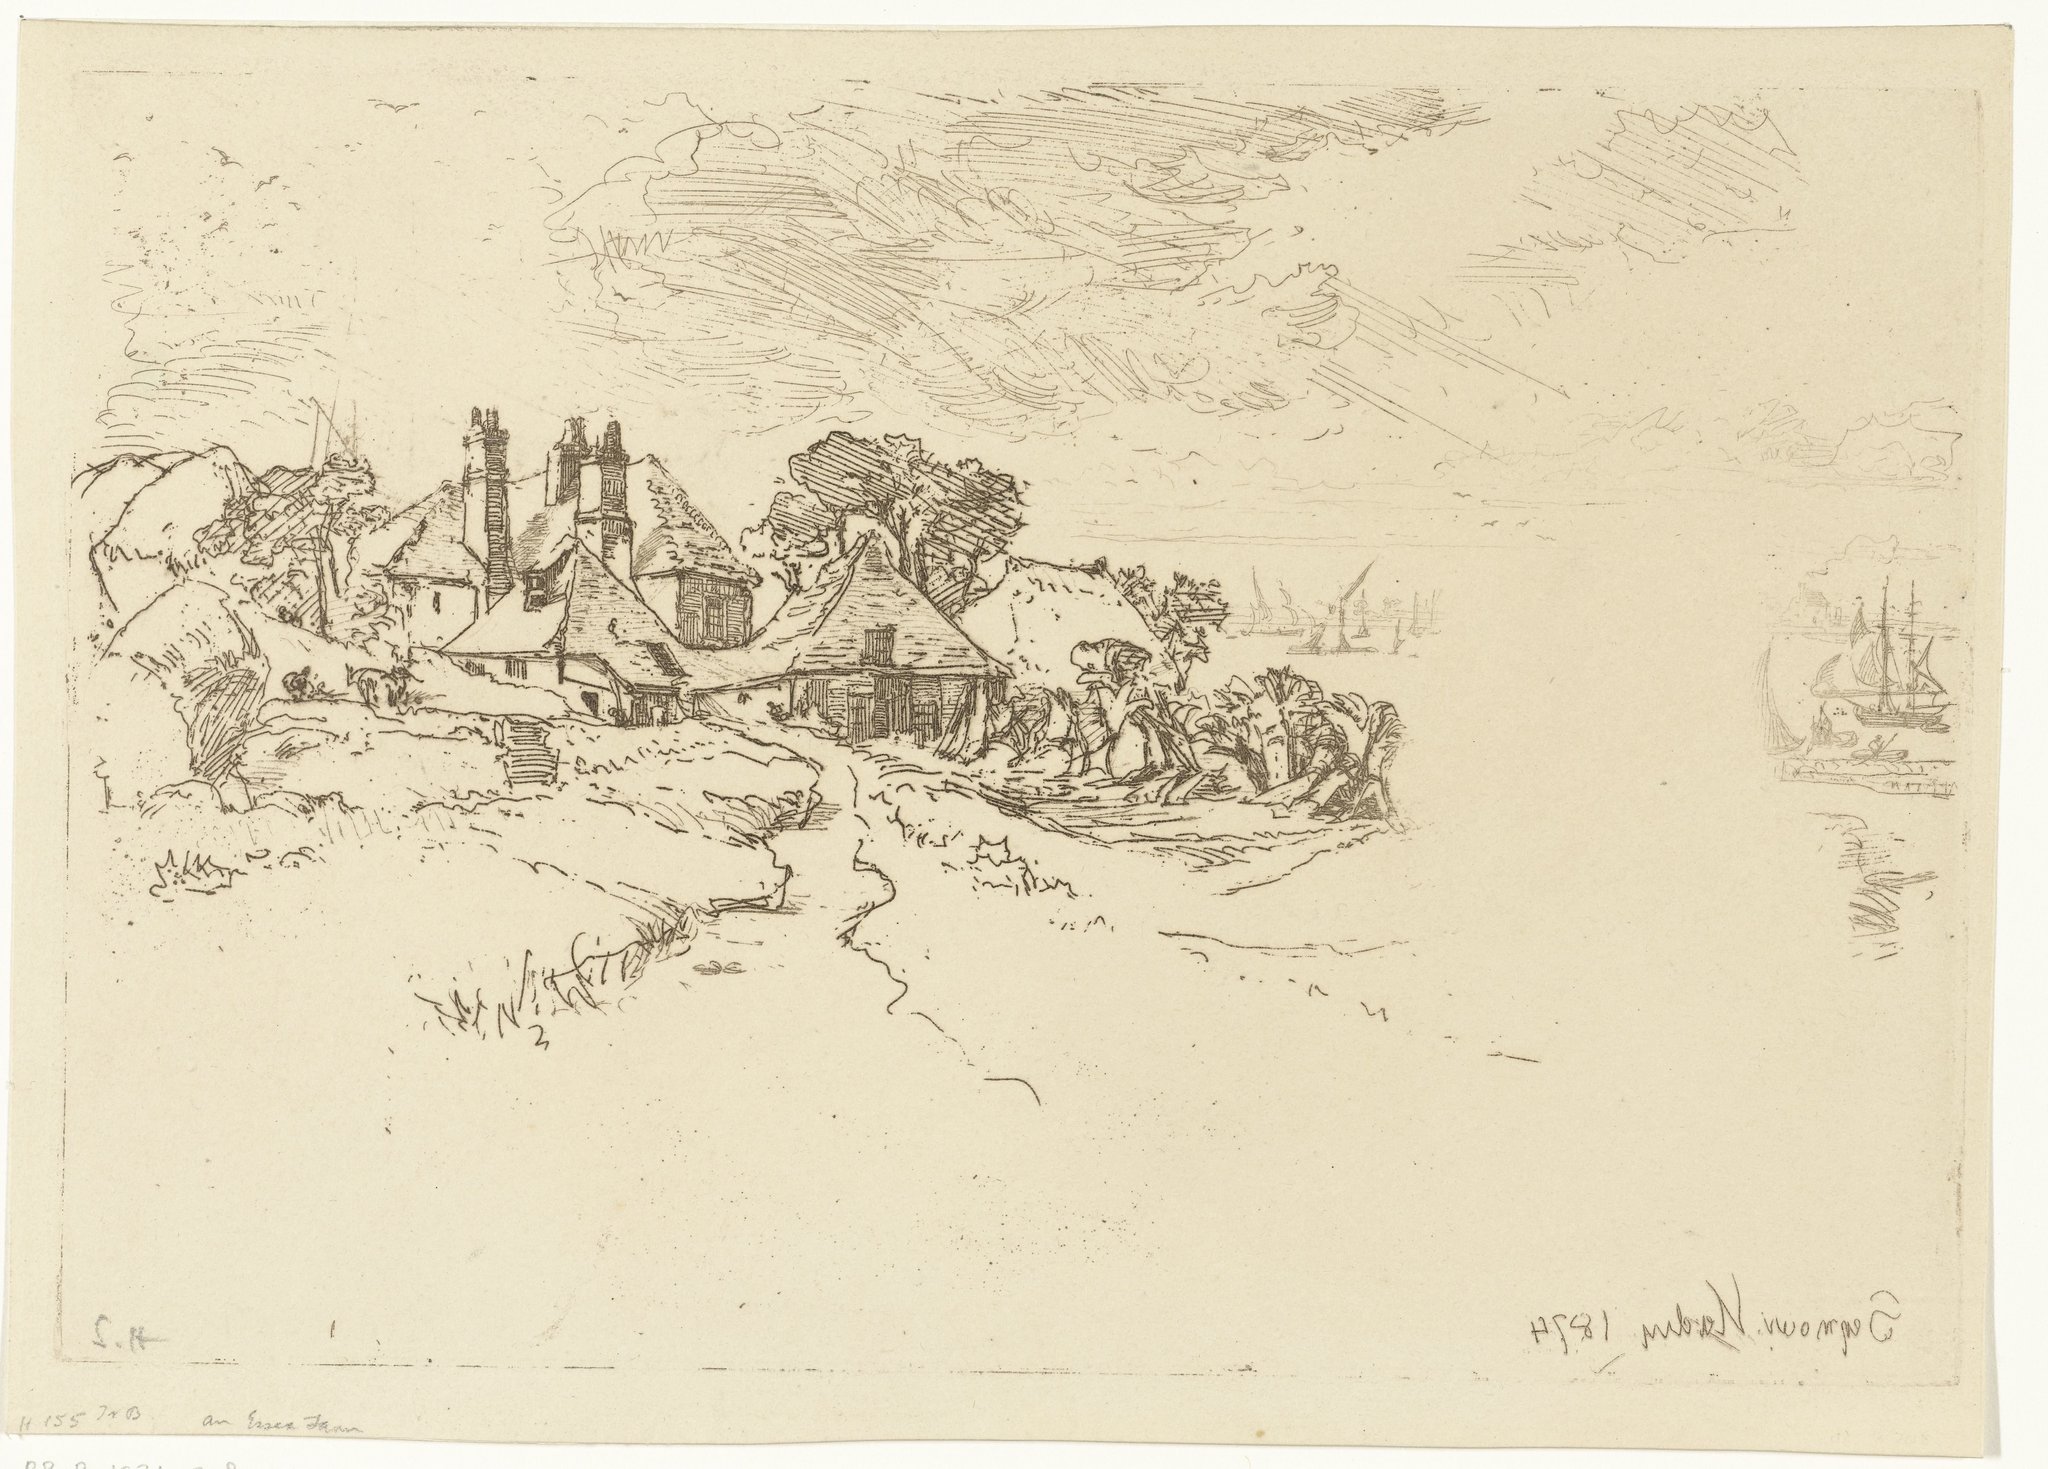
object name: print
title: An Essex Farm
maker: francis seymour-haden (sir)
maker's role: print maker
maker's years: 1818-1910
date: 1874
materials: paper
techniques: printing, printmaking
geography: england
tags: river, farm or solitary house in landscape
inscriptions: collector's mark: ‘L’, collector's mark: Lugt 2228, collector's mark: Lugt 3759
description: Een boerderij tussen de bomen, op de oever van een rivier met zeilschepen.